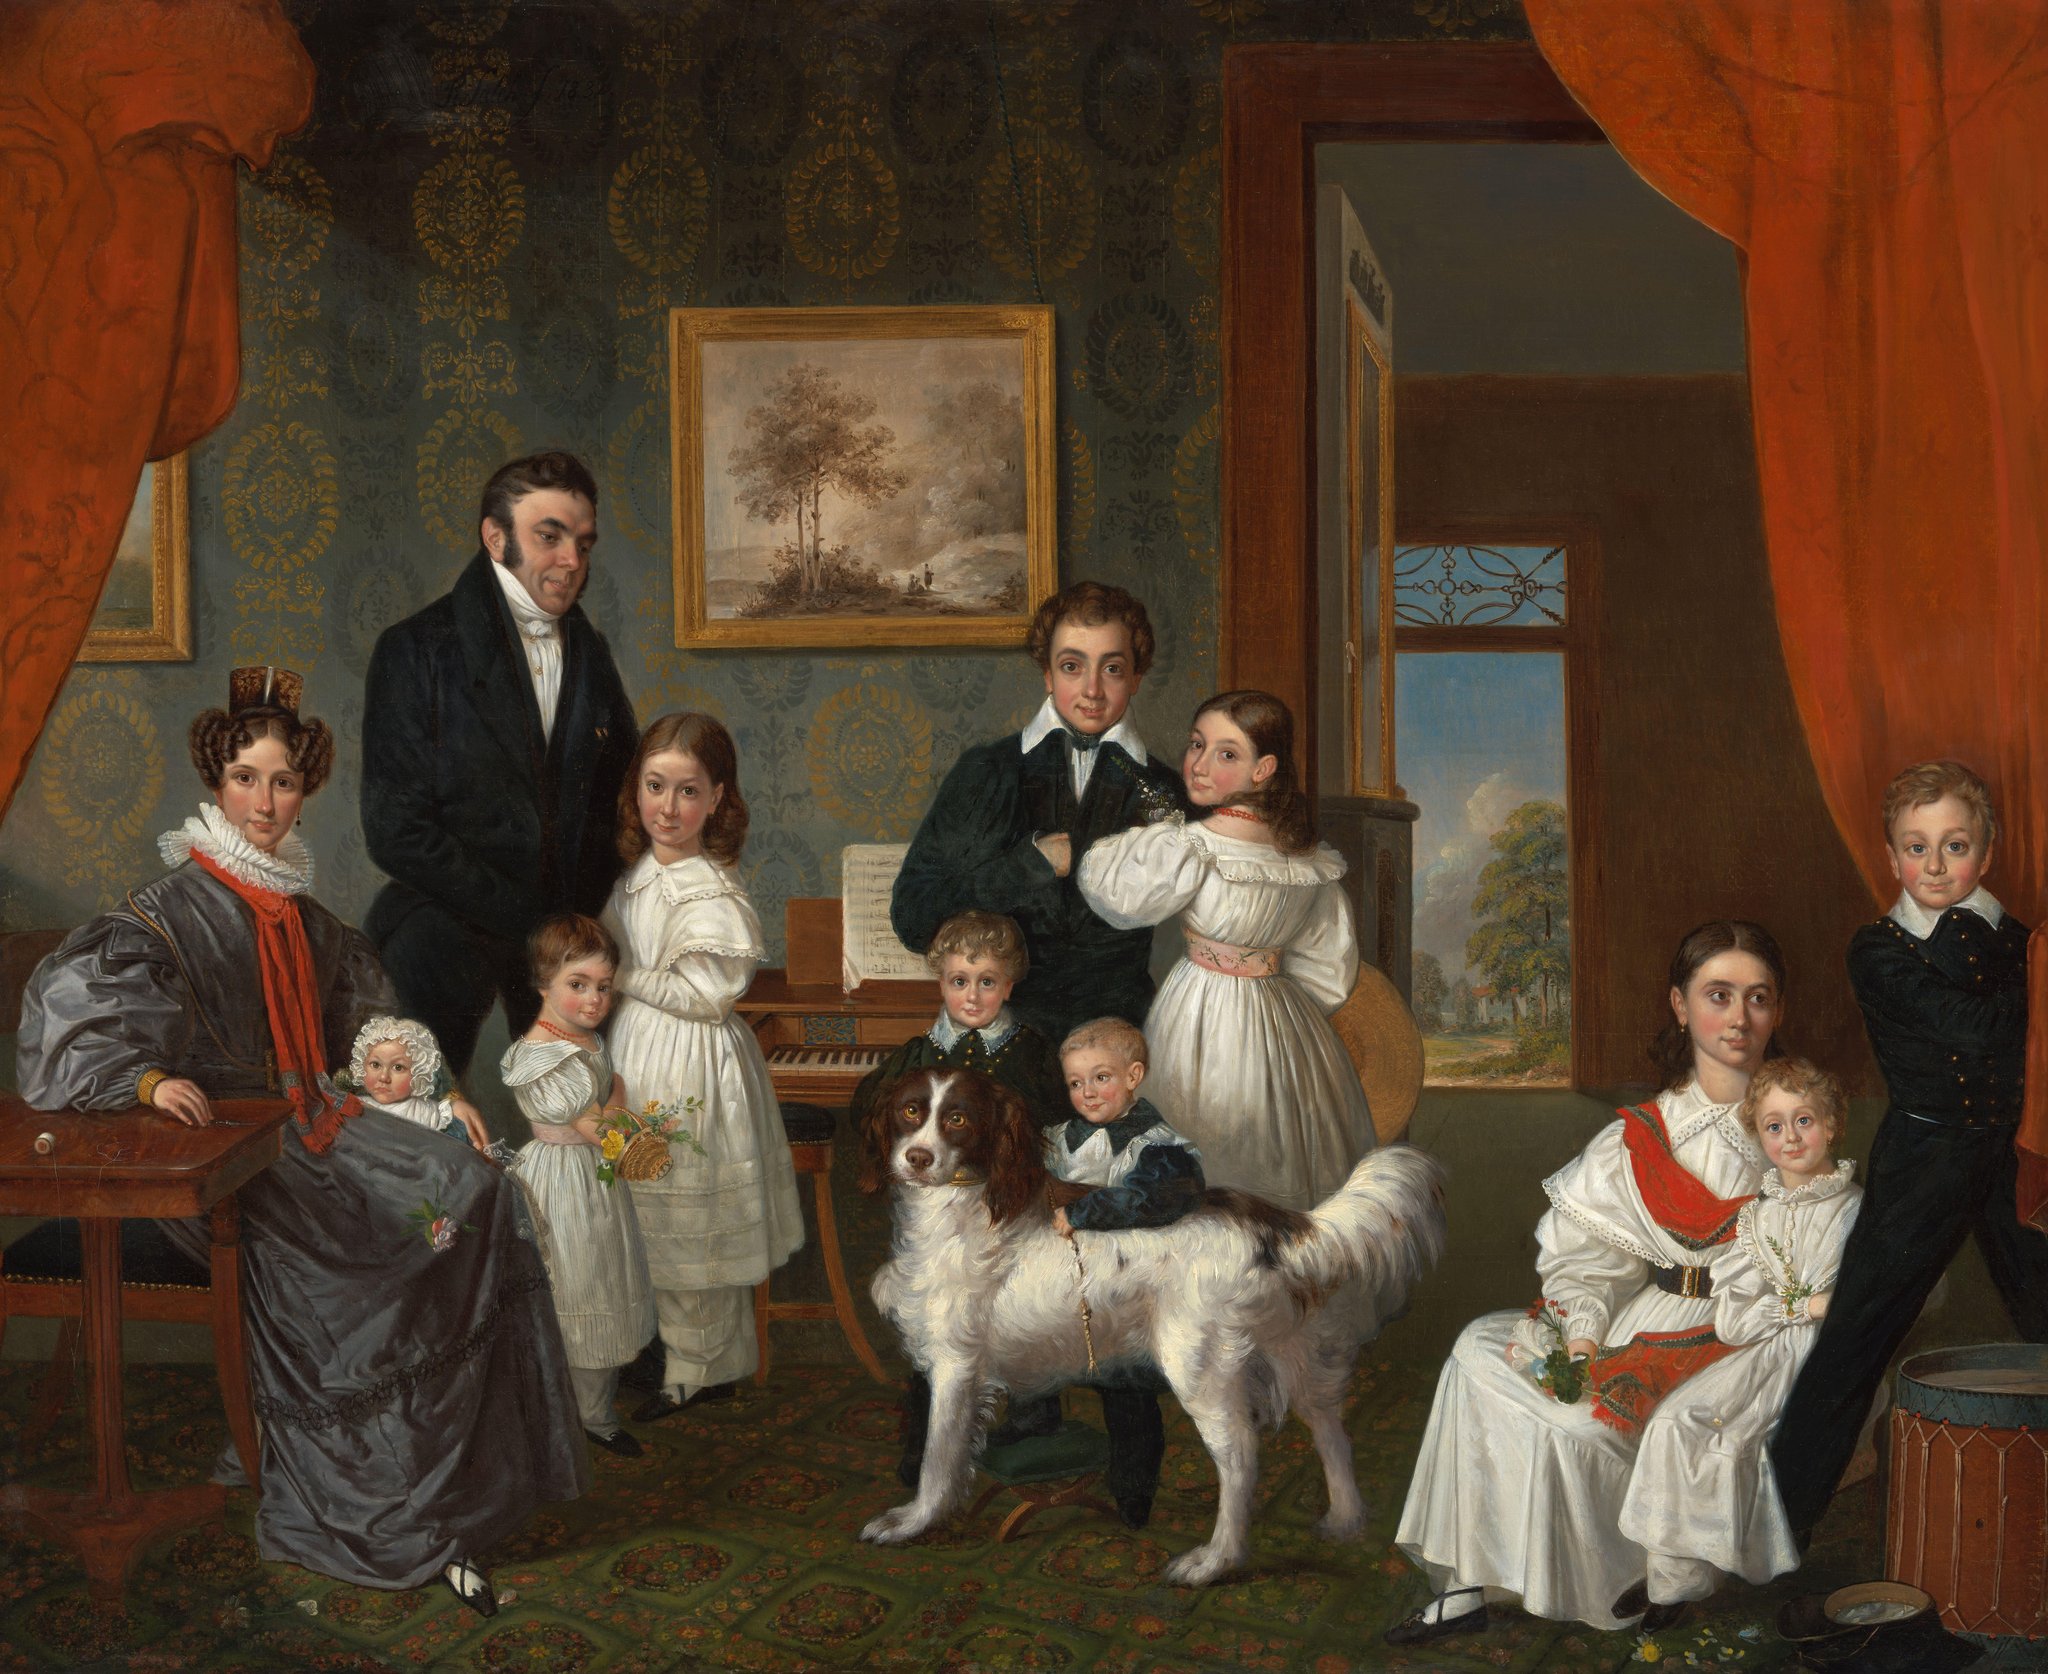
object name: painting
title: Portret van de familie Baud in hun buitenhuis in Voorburg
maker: raden sarief bastaman saleh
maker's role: draughtsman, painter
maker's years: 1814-1880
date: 1831-1832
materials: canvas, oil, paint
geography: netherlands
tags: the hague, voorburg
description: Portret van een groep bestaande uit 12 personen en een hond. De groep is bijeen in een muziekkamer. Aan de wand hangt een wintergezicht. De kamer achter de muziekkamer geeft uitzicht op een openstaande deur met een landschap in het verschiet.